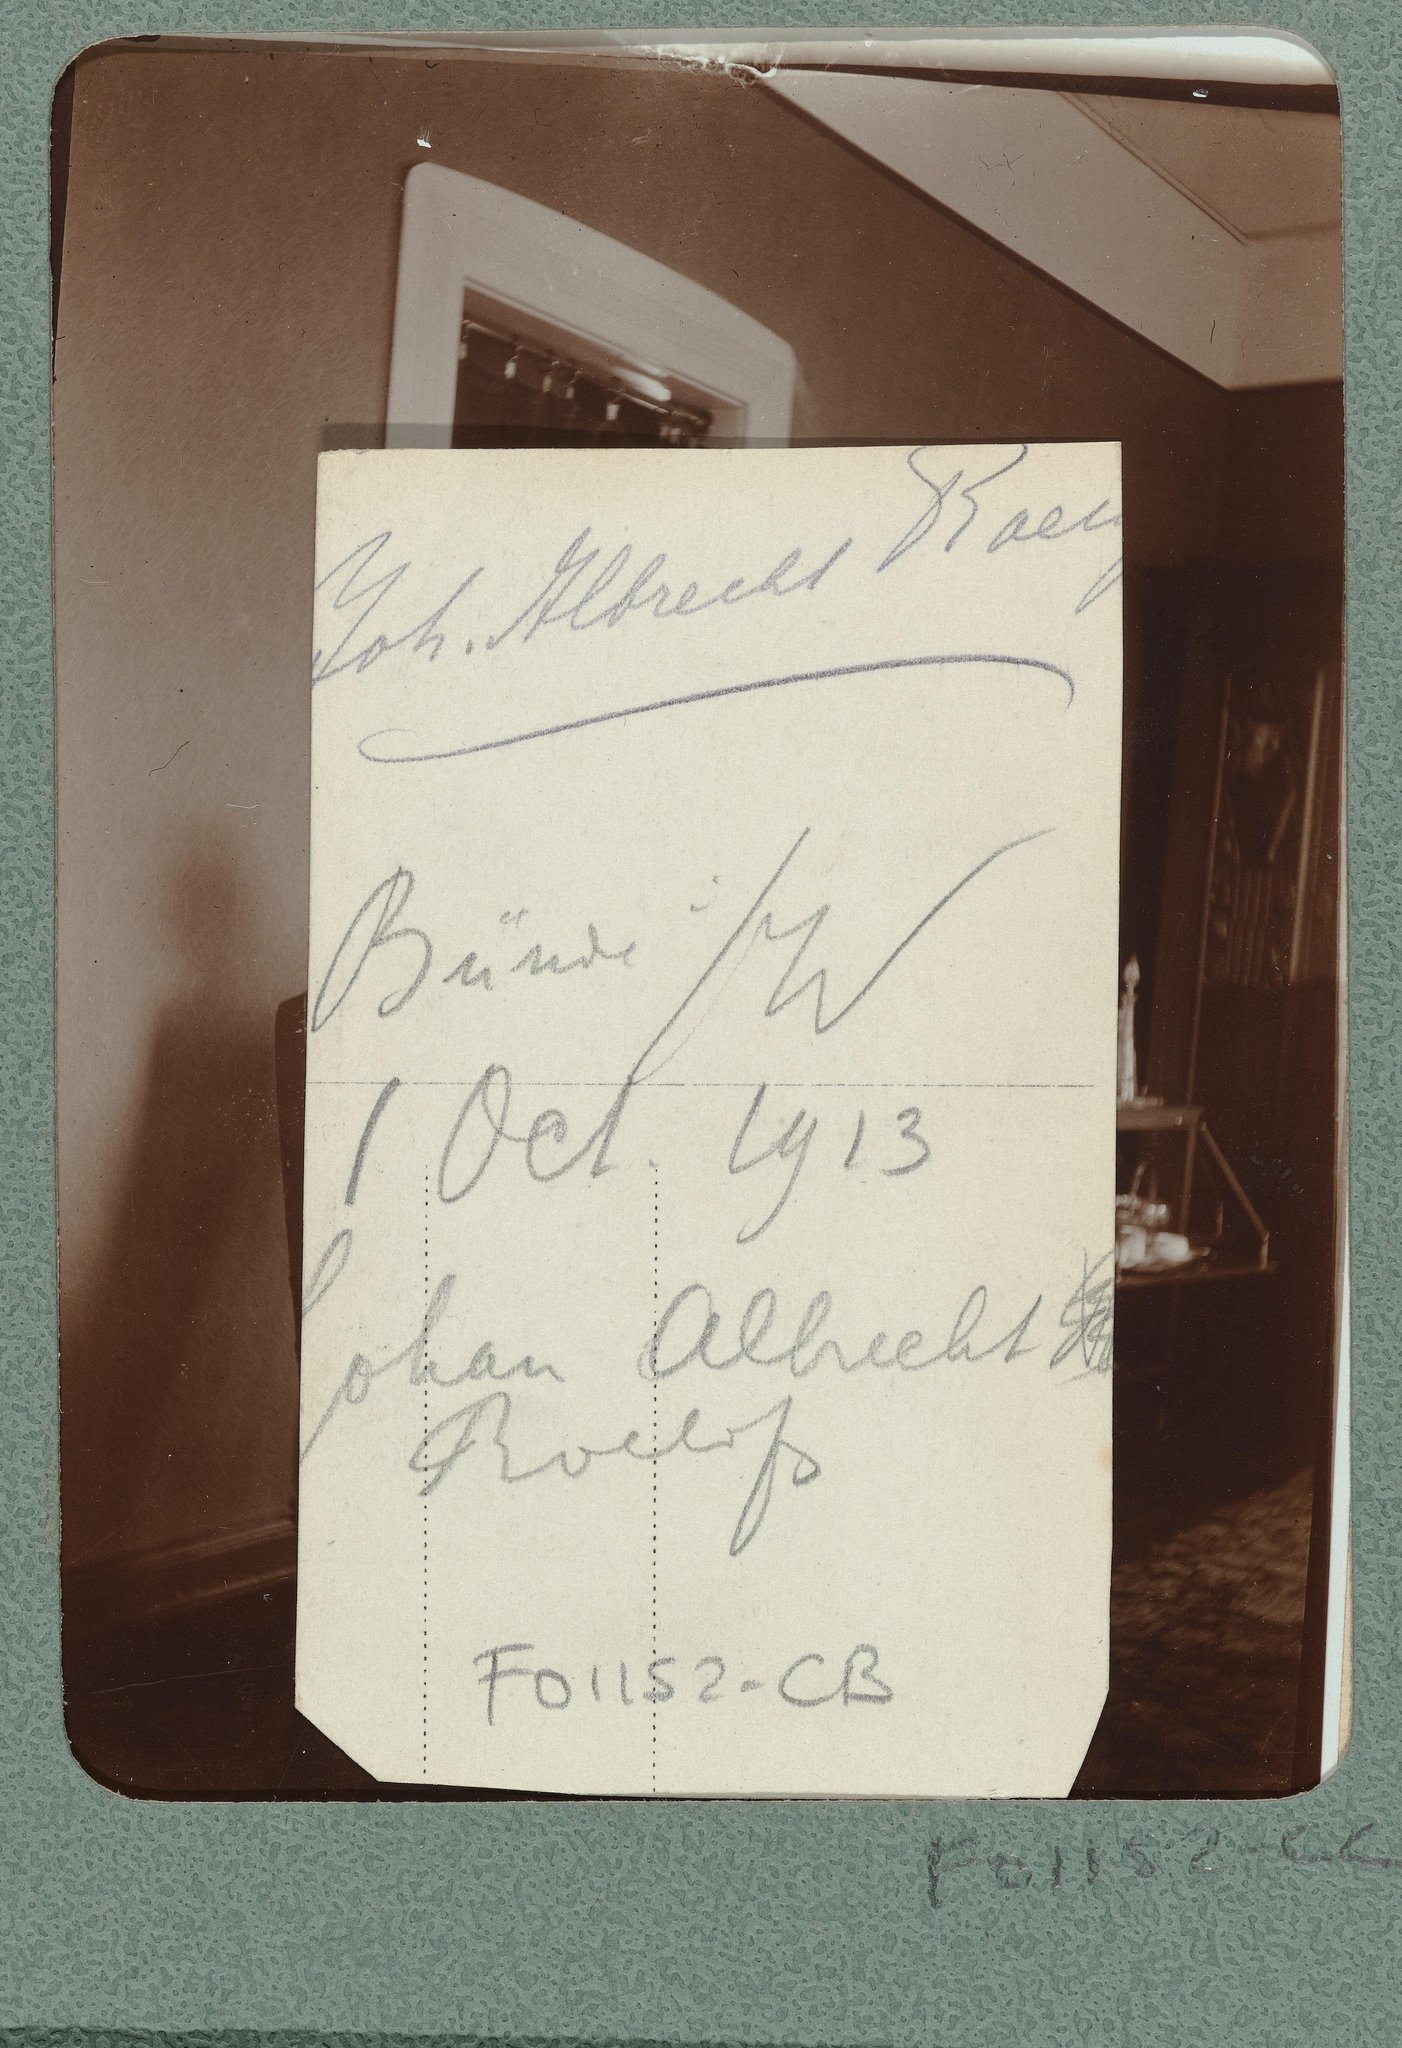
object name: album leaf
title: Portret van een vrouw met een baby in de tuin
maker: christiaan otto roelofs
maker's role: fotograaf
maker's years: 1882-1970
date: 1913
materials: photographic support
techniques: gelatin silver print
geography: netherlands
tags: historical persons, mother and baby or young child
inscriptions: inscription: ‘Joh. Albrecht Roelofs/ Zijnde/z/ 1 Oct 1913/ Johan Albrecht/ Roelofs’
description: Deze foto maakt deel uit van een album. Deze foto ligt los in het album.